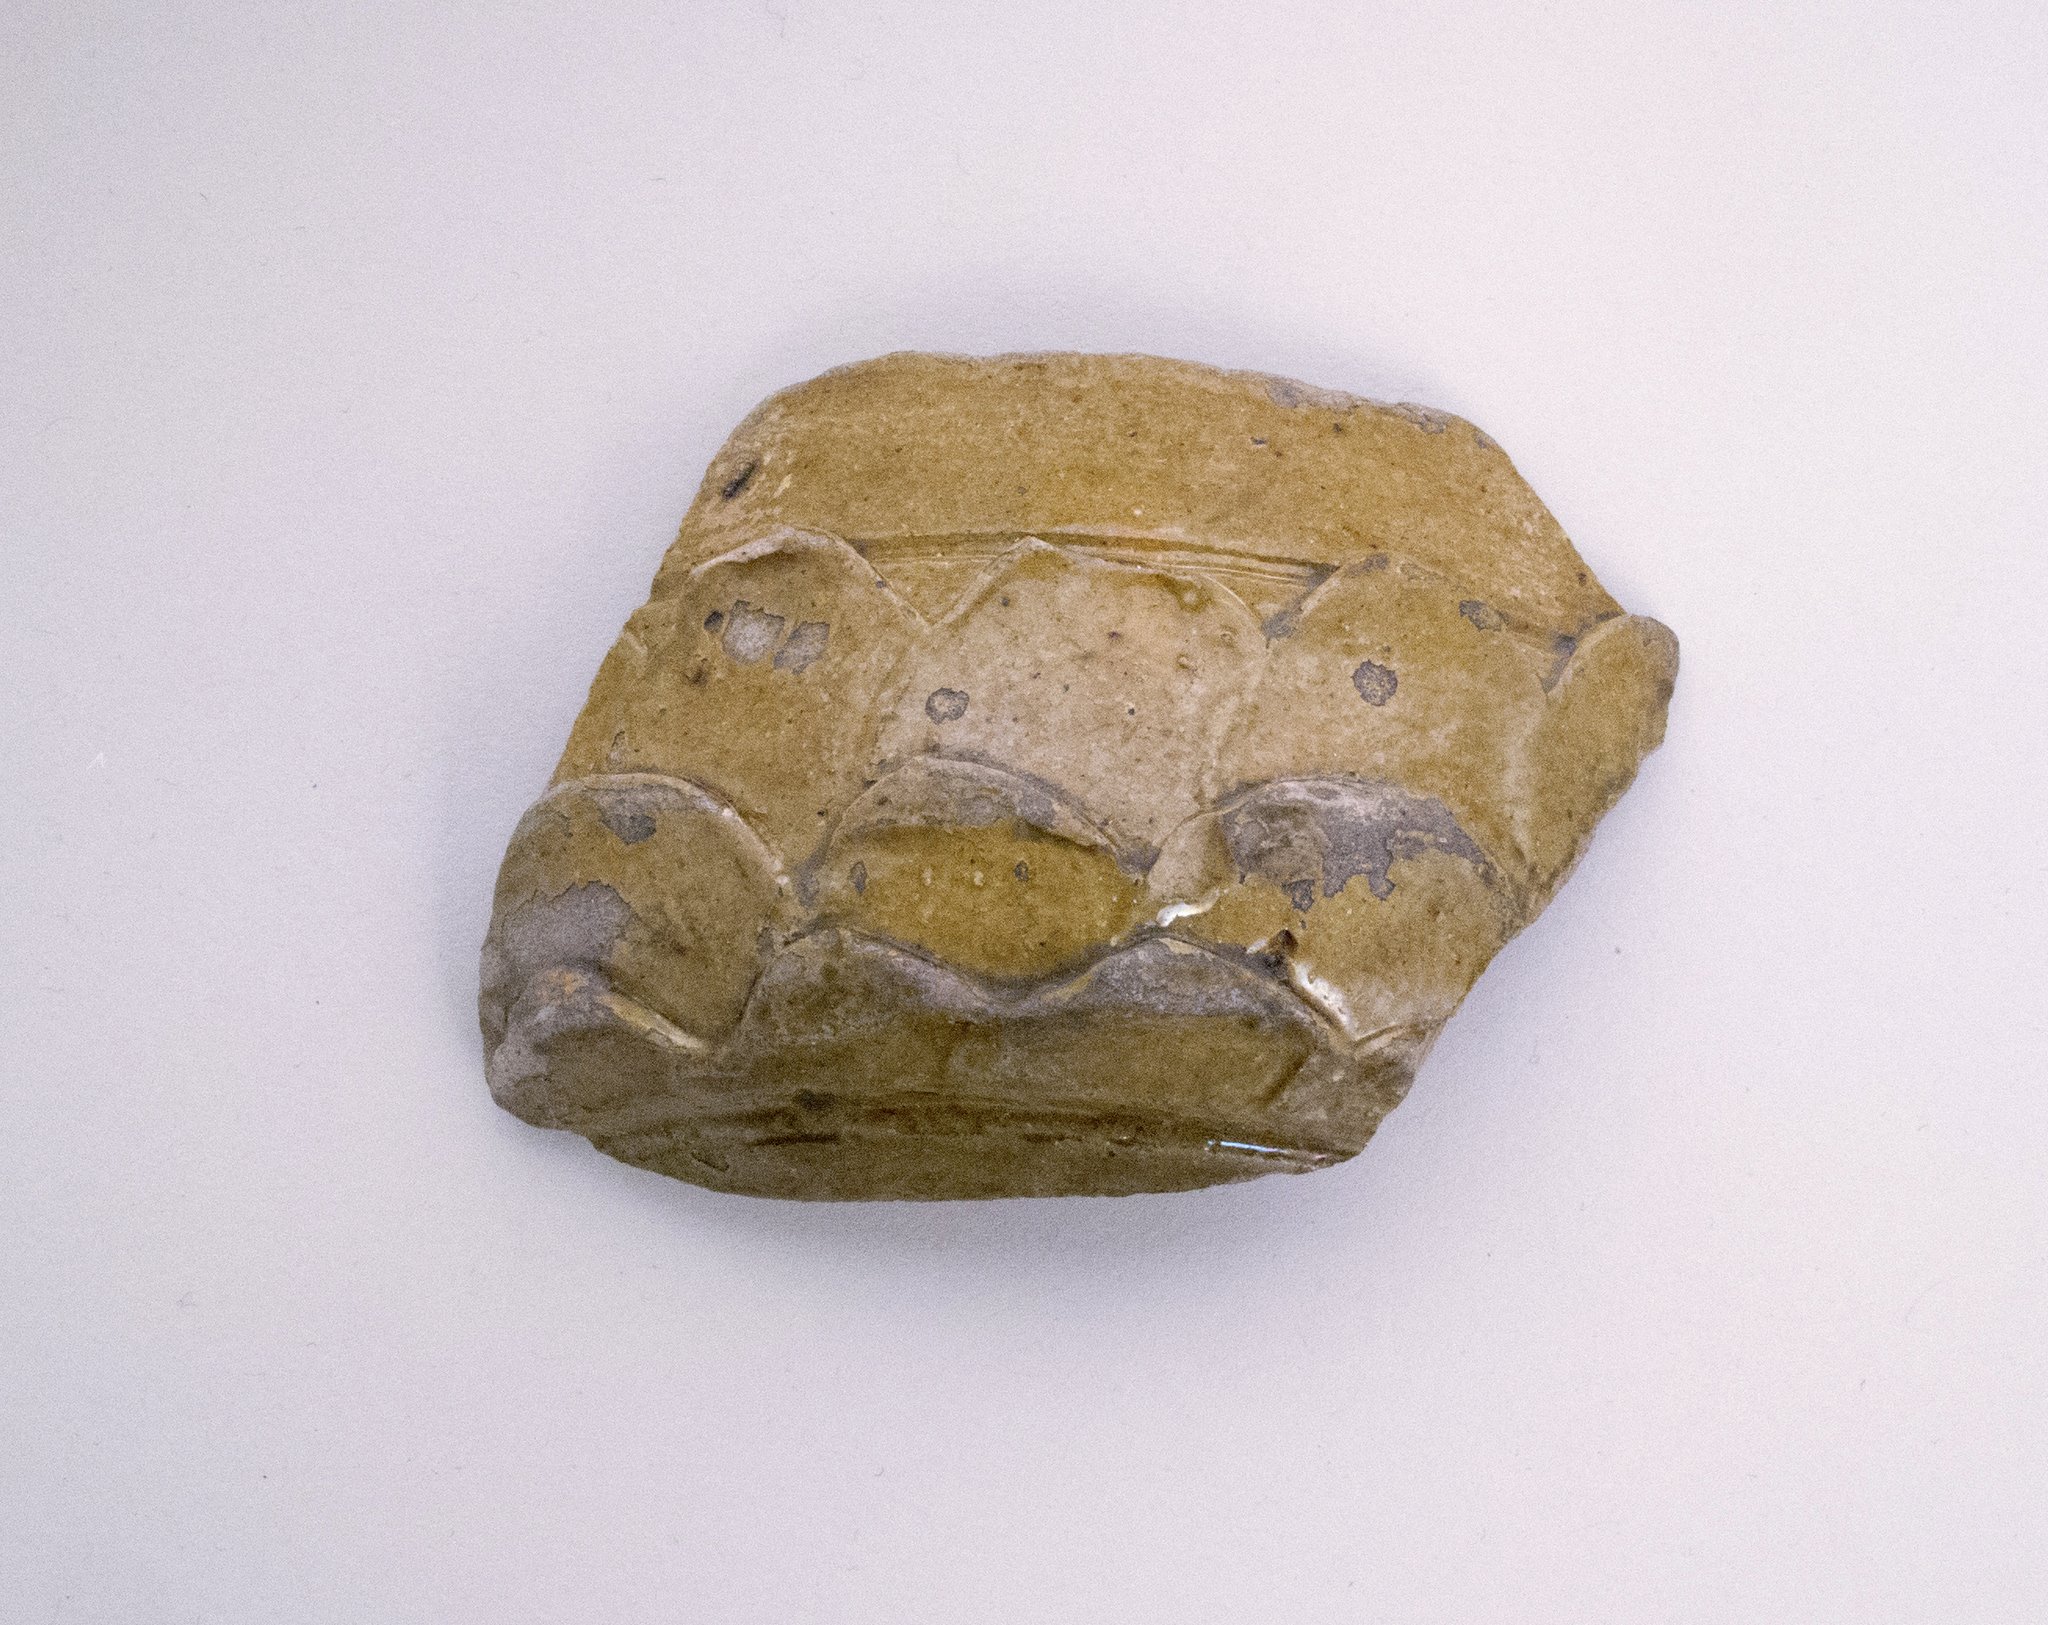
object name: vase fragment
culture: roman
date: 670 BCE-330 CE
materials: terracotta